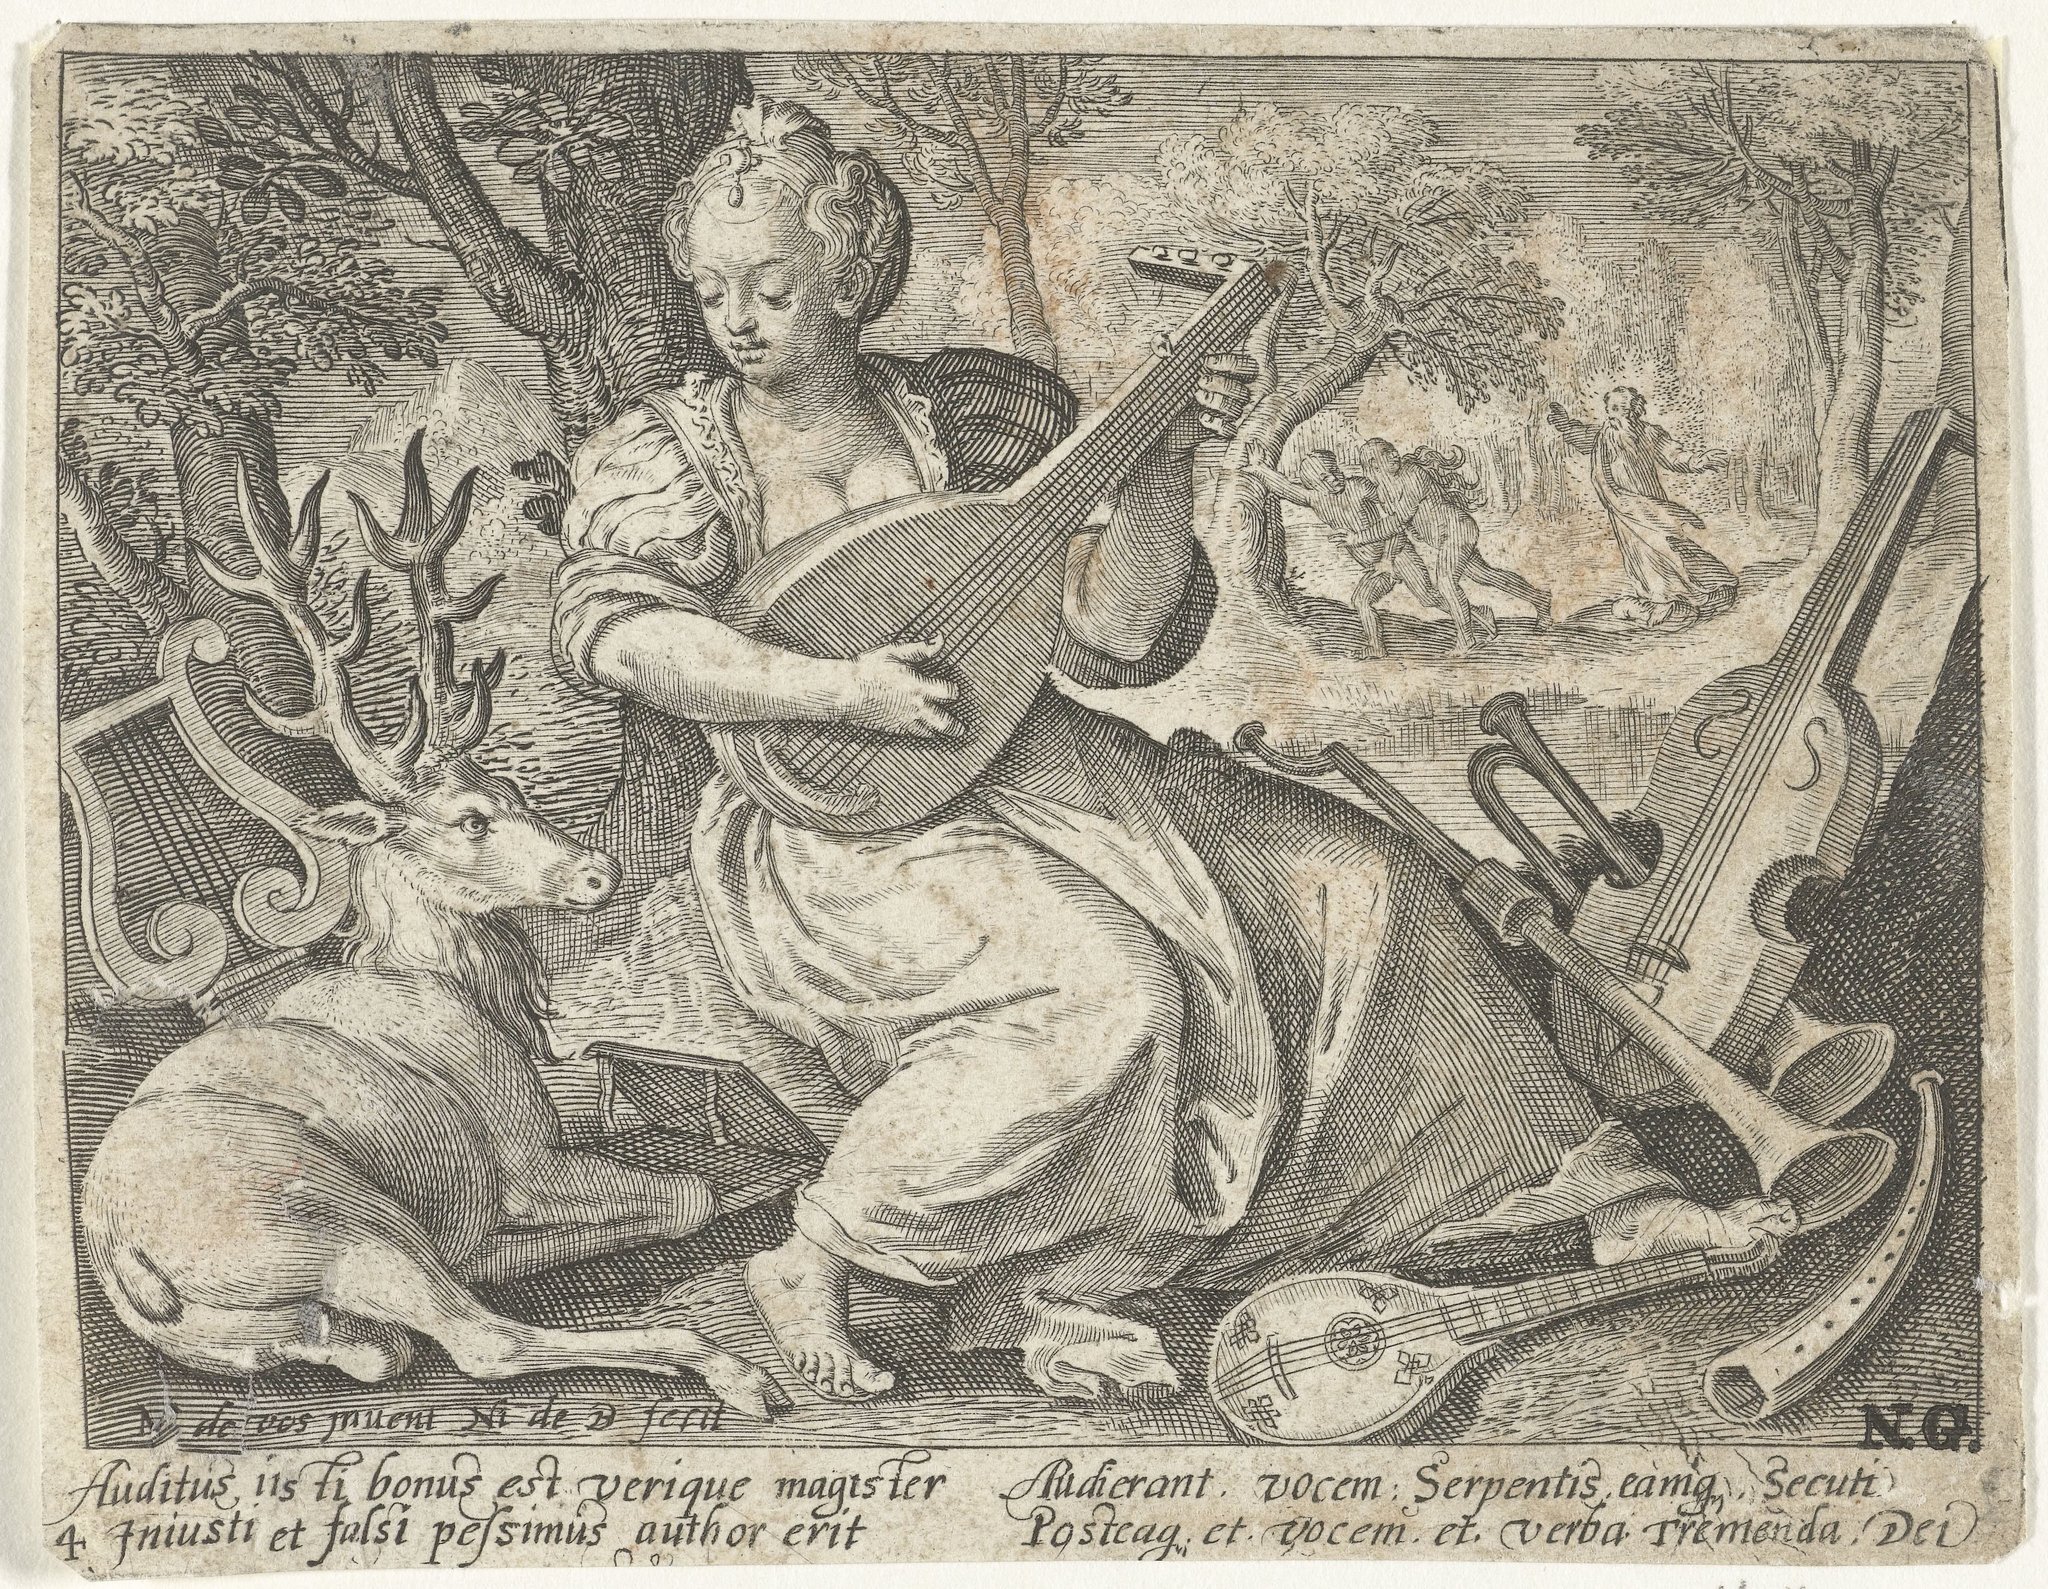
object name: print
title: Zintuig gehoor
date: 1581-1656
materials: paper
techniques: engraving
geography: netherlands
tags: hearing, listening (one of the five senses), hoofed animals: stag, adam and eve discover their nakedness; they cover themselves with their hands or with leaves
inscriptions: collector's mark: Lugt 2228, collector's mark: Lugt 1967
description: Vrouw als personificatie van zintuig gehoor zittend in landschap met instrumenten, zij speelt op een luit terwijl een edelhert naast haar ligt. Op de achtergrond is een scène uit Genesis weergegeven: Adam en Eva verbergen zich voor God uit schaamte. In marge onder twee regels Latijn.